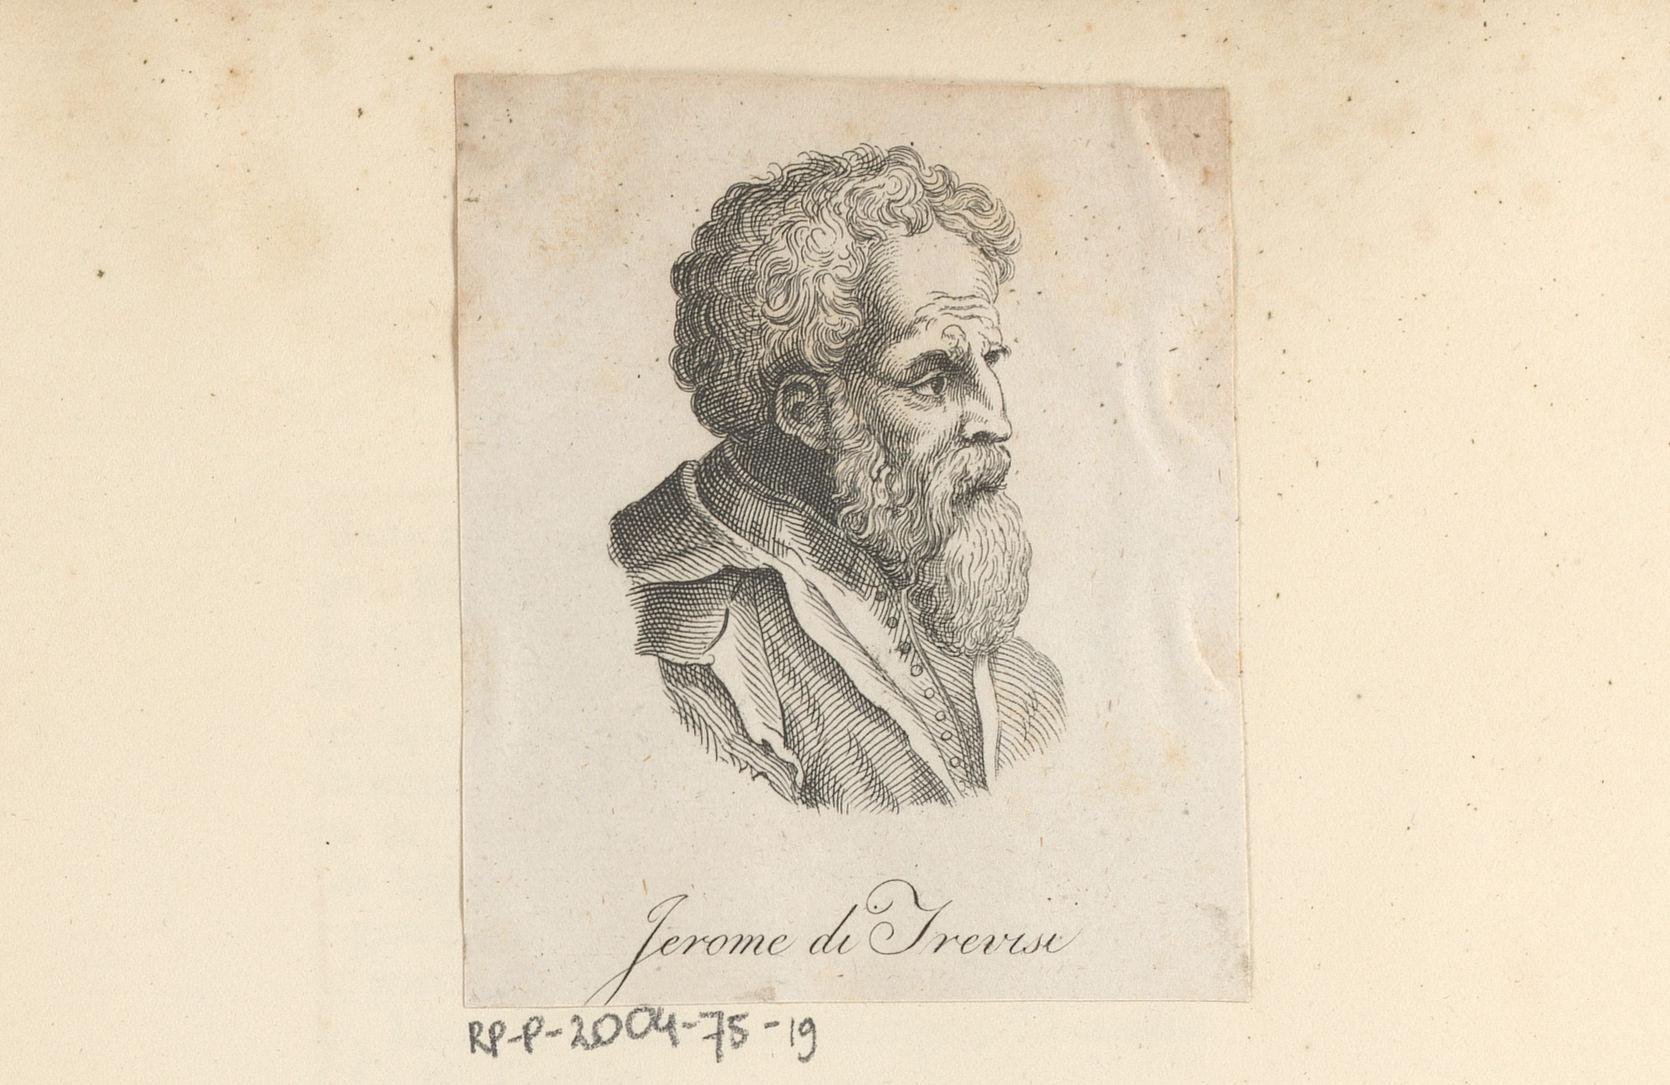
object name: album leaf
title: Portret van Jerome Trevisi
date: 1750-1800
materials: paper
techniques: engraving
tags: jerome di treviso, historical persons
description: De samensteller heeft deze prent in het album geplakt als illustratie bij: Pilkington, Matthew en Johann Heinrich Füssli. A dictionary of painters, from the revival of the art to the present period. 4 dln. Londen: John Crowder, 1805, dl. 4, p. 568.